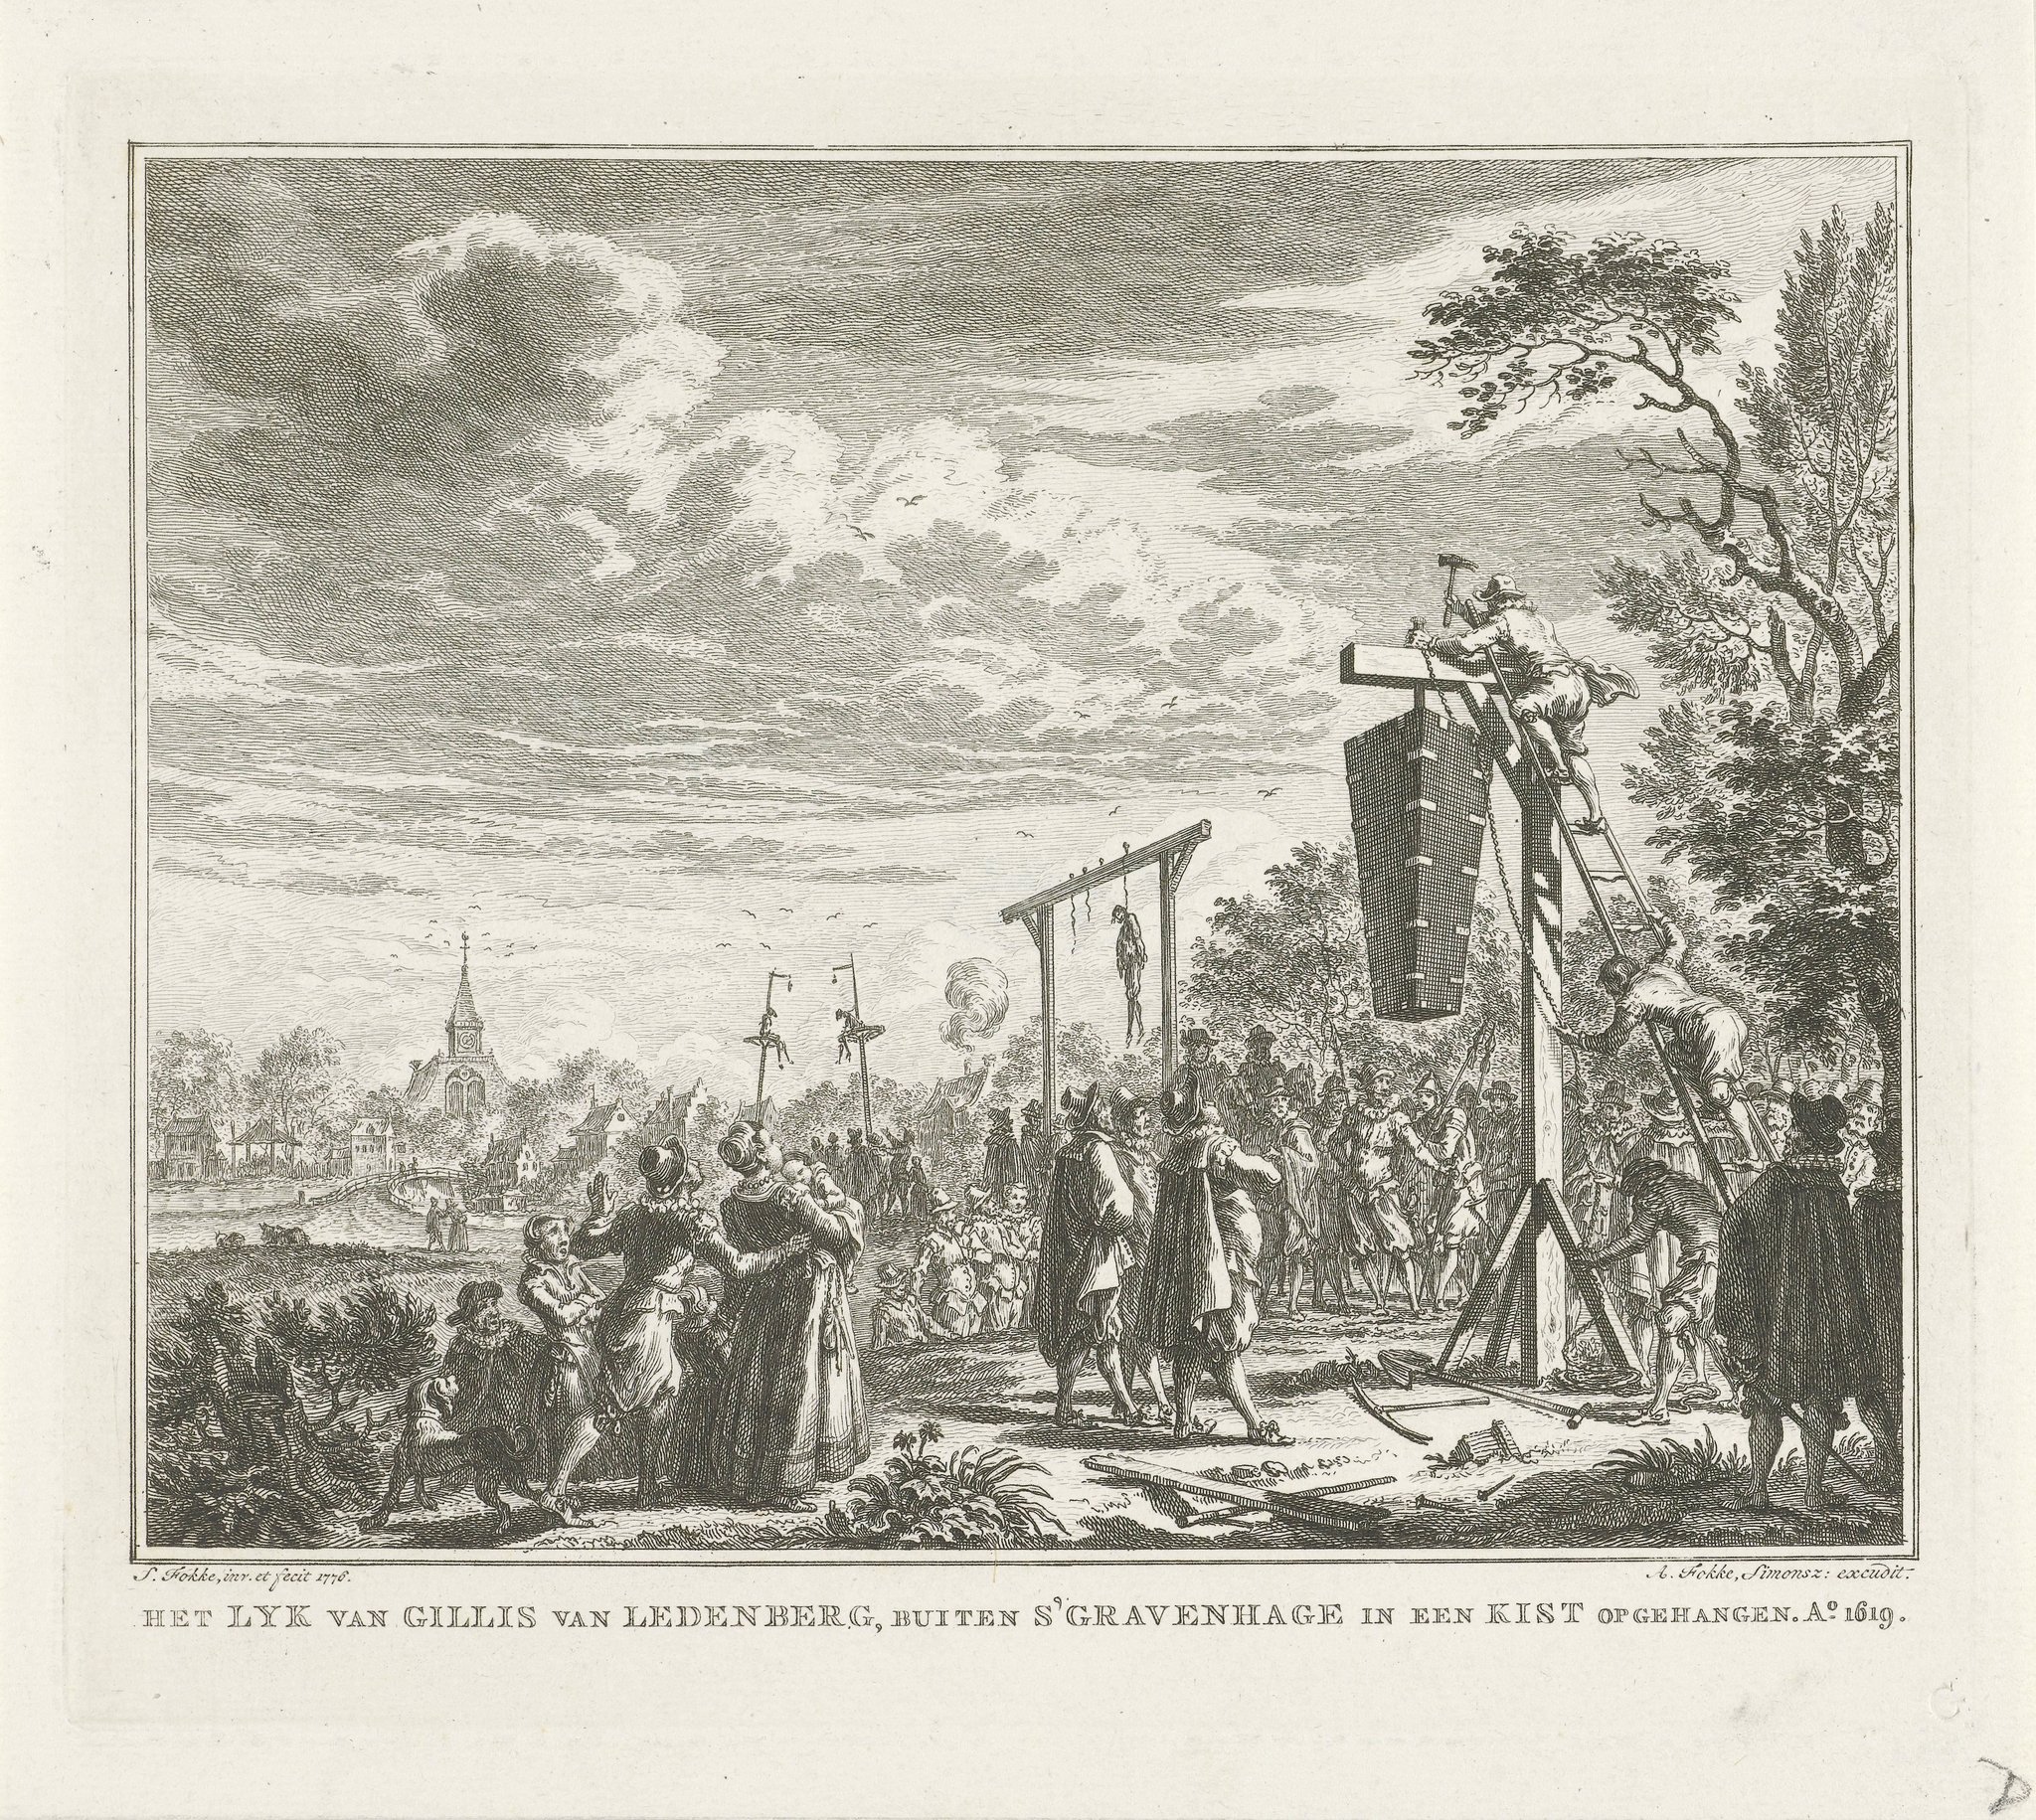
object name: print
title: Het Lyk van Gillis van Ledenberg, buiten 's Gravenhage in een Kist opgehangen. Ao 1619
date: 1776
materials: paper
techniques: etching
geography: amsterdam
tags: utrecht, death penalty, execution, the hague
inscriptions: collector's mark: Lugt 2228, collector's mark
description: Aan een paal wordt de kist met hierin het lijk van Gillis van Ledenberg, secretaris van Utrecht, opgehangen. Omstanders kijken toe hoe de kist wordt bevestigd.